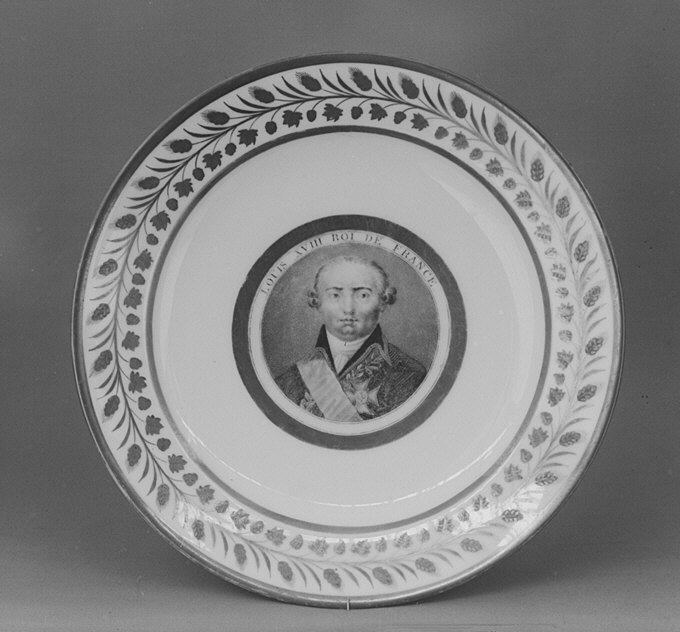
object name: plate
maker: rue de popincourt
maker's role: factory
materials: hard paste porcelain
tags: men,portraits,flowers